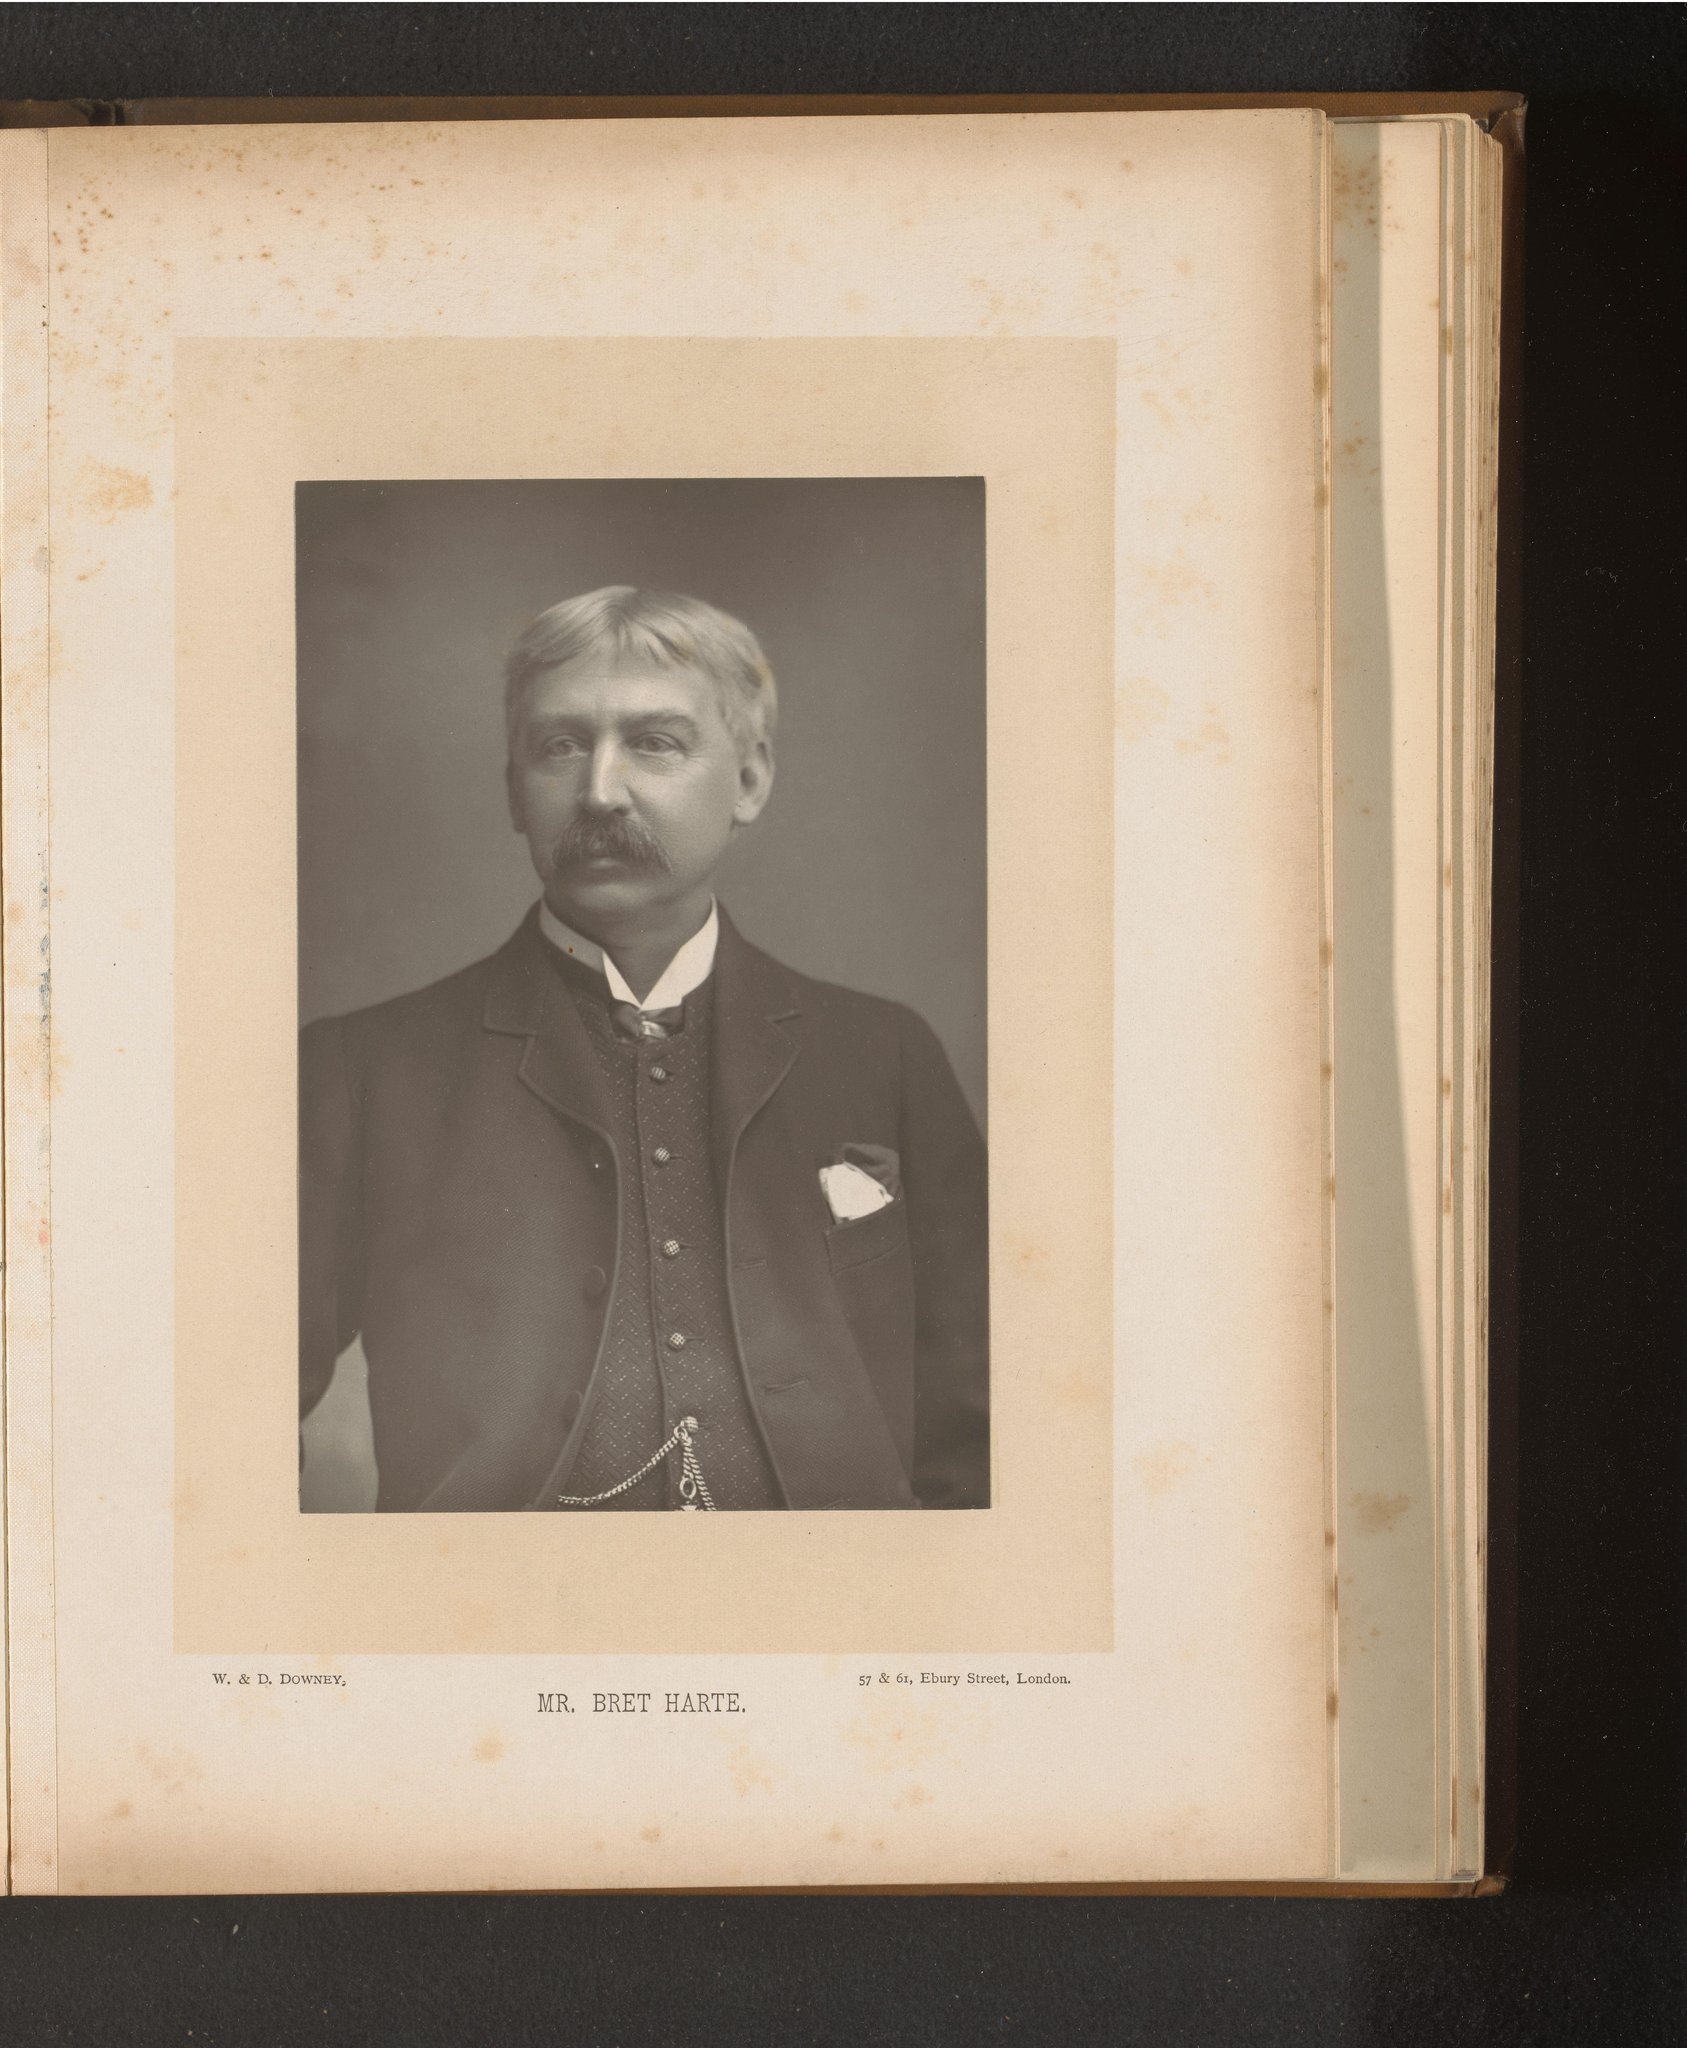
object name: photomechanical print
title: Portret van Francis Bret Harte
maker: Anonymous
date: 1881-1891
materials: paper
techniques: woodburytype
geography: london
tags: portrait of a writer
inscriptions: inscription: ‘57 & 61, Elbury Street, London.’